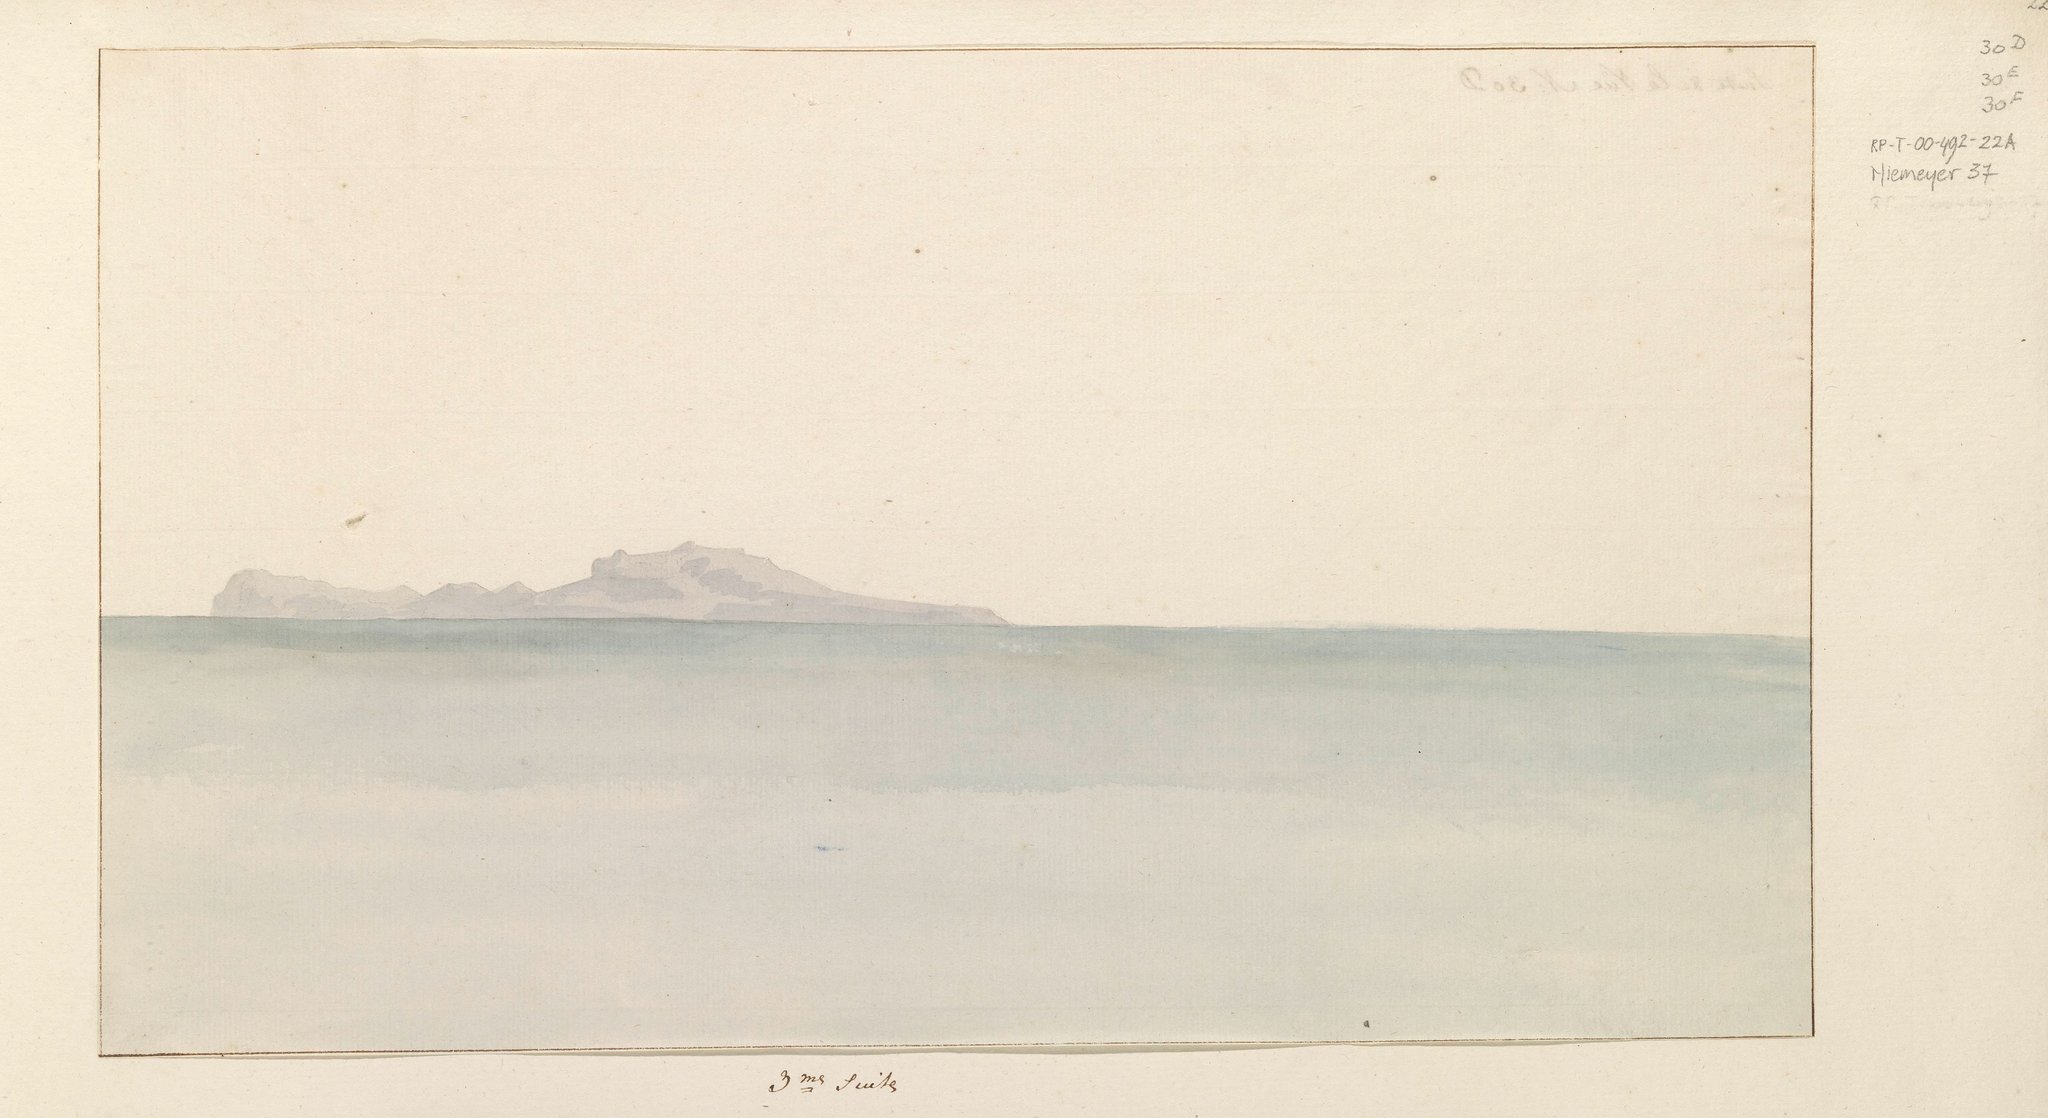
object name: watercolor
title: Suite de la vue de No. 30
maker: louis ducros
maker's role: draughtsman, print maker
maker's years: 1748-1810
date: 1778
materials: chalk, paper, watercolor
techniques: brush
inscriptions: number: ‘Suite de la vue de No. 30D’